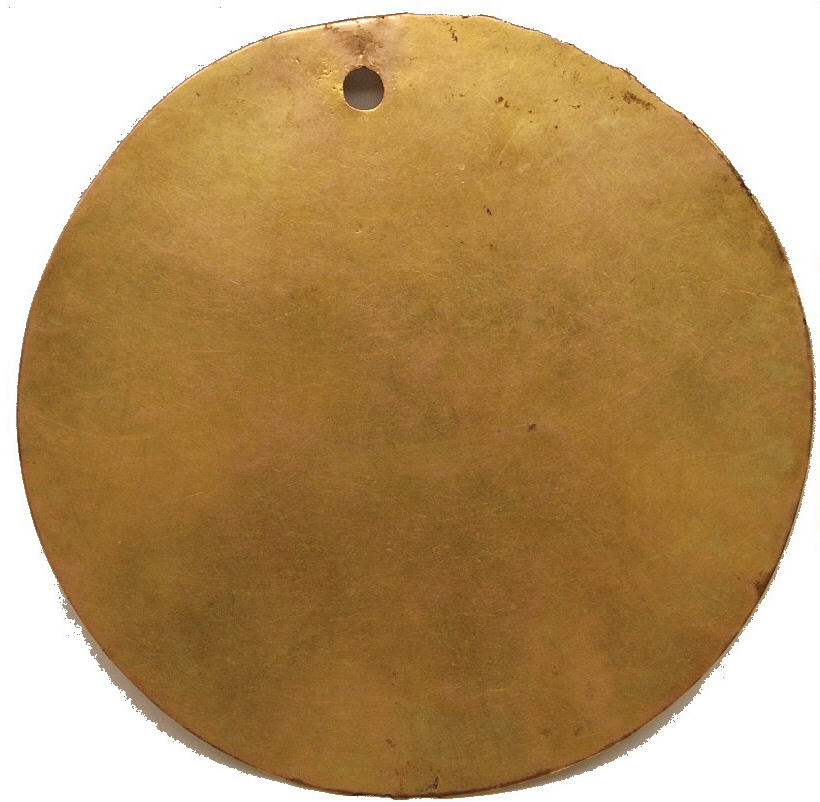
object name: disk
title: Ornamental Disk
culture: capuli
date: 801-1300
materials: gold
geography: ecuador